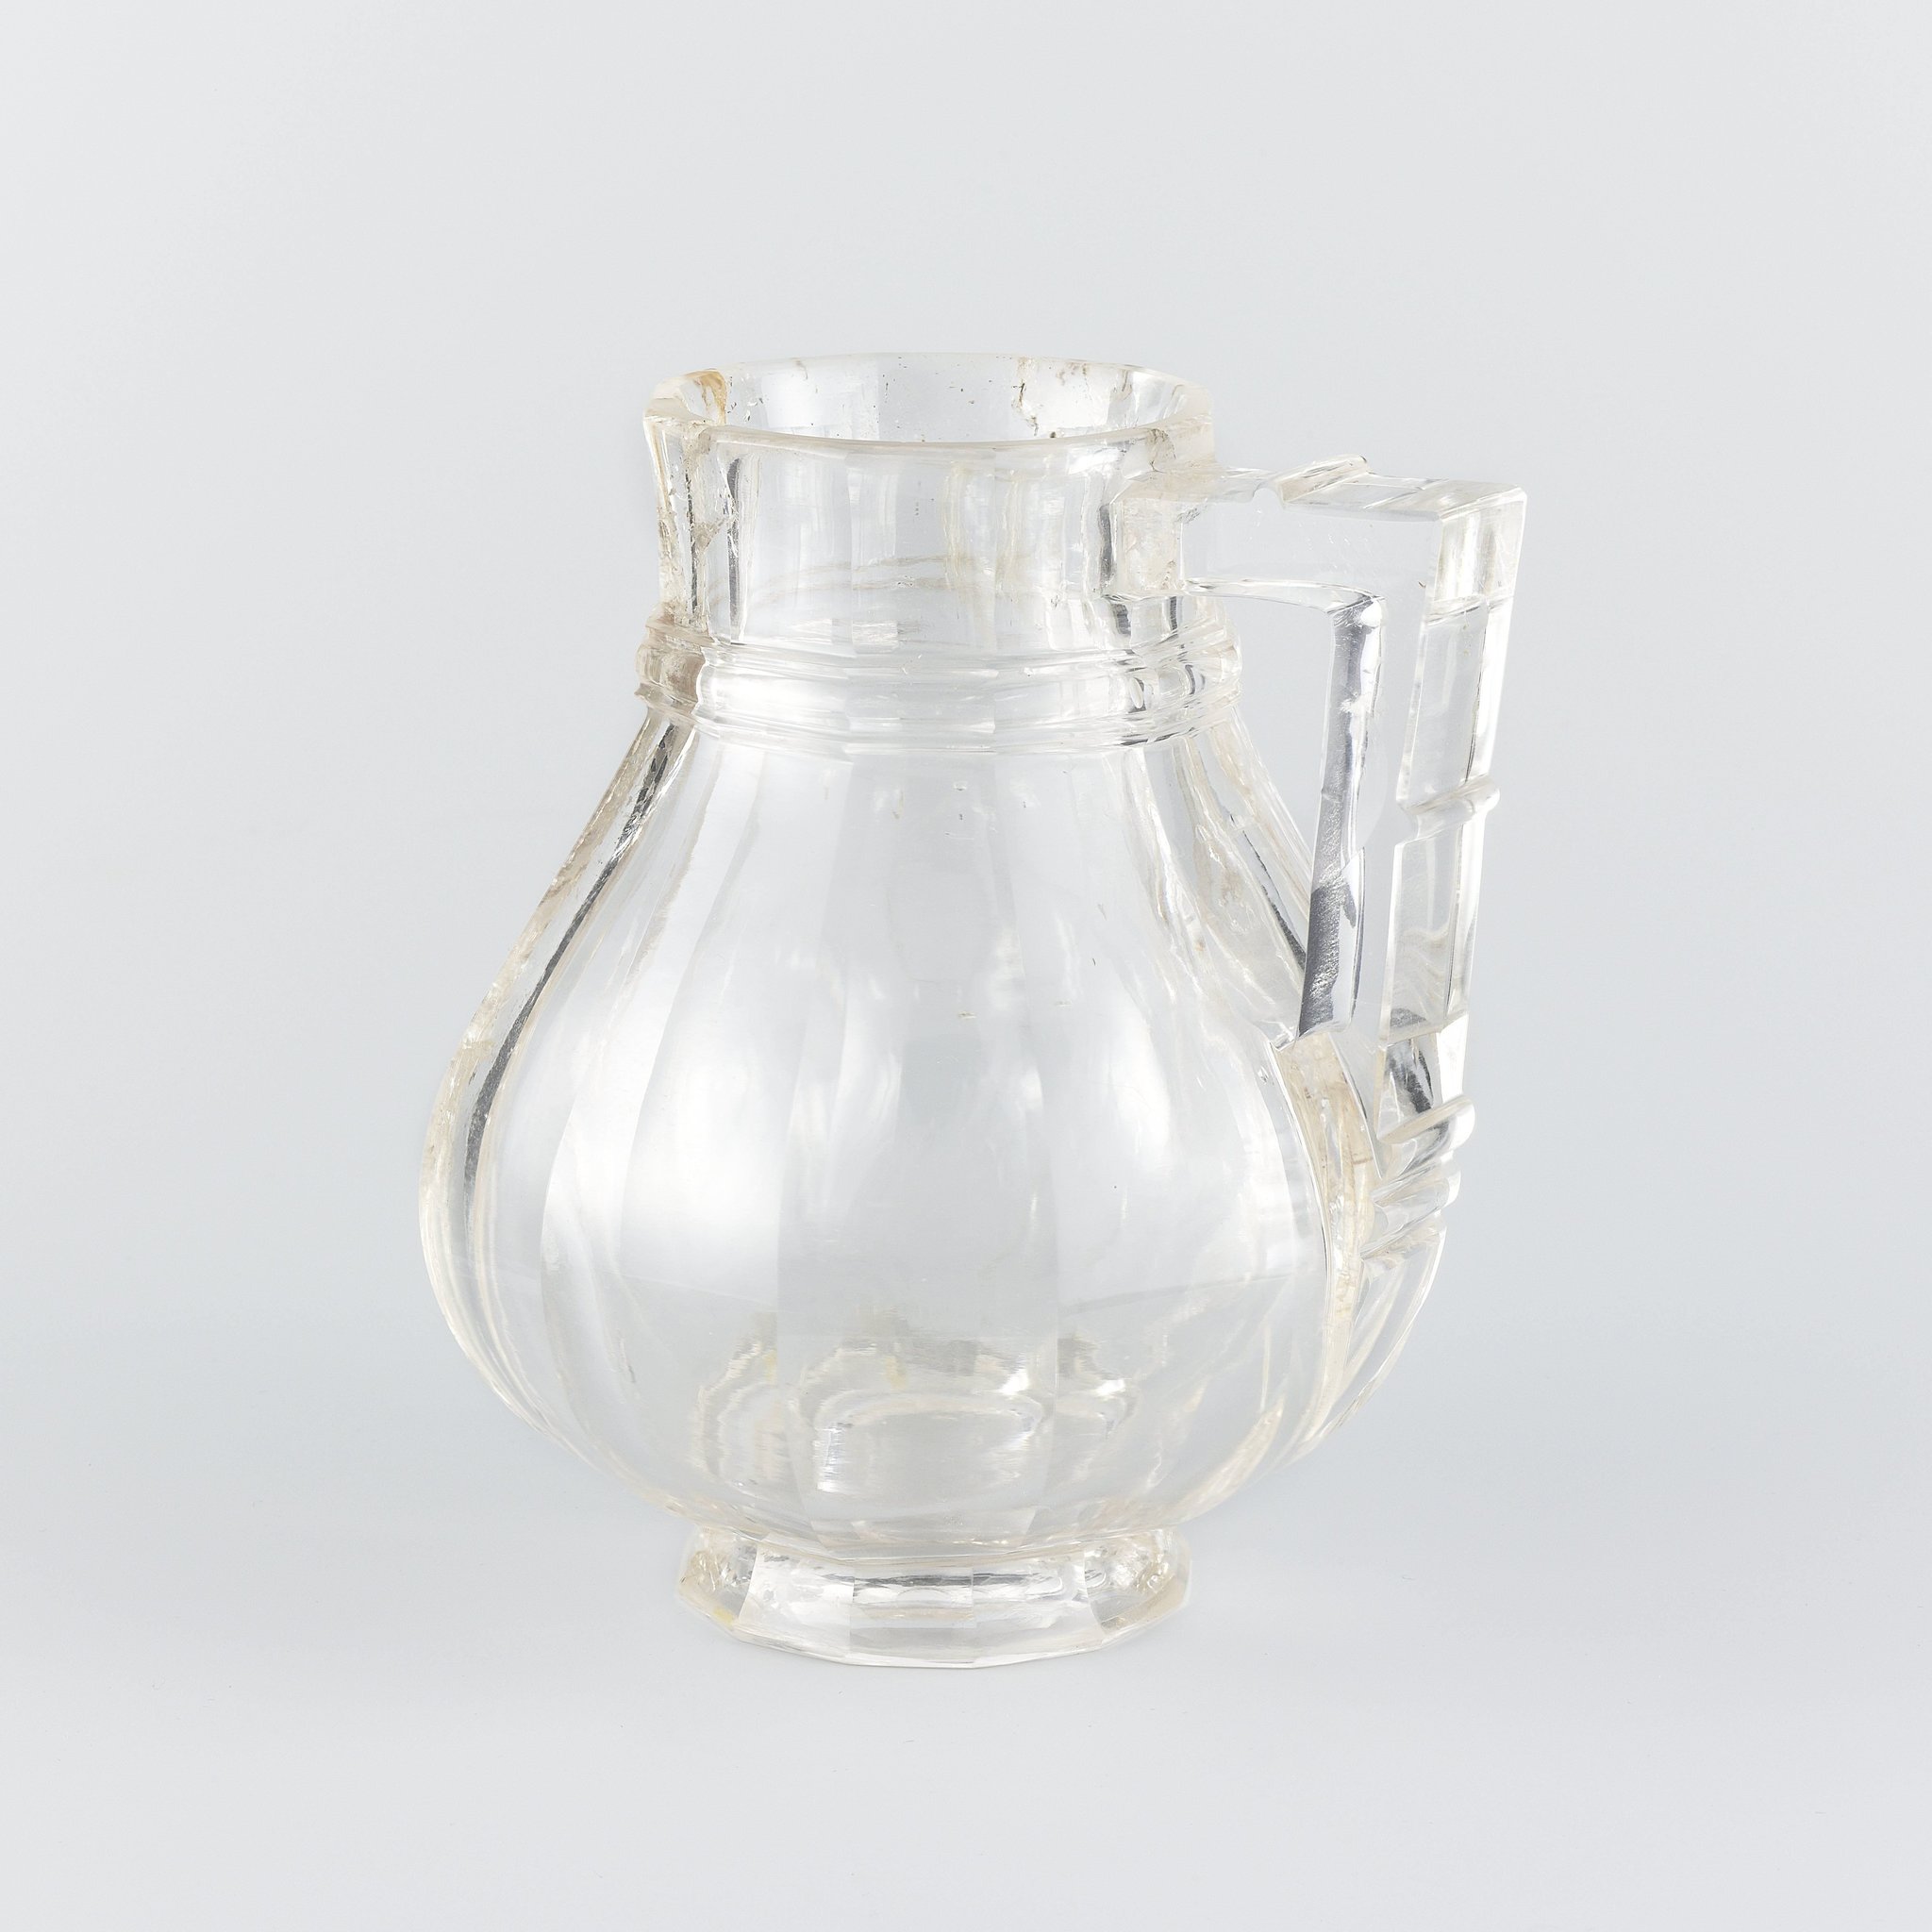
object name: ewer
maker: Anonymous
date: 1350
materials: silver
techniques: gilding, grinding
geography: southern italy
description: Kan van bergkristal met verguld zilveren monturen. Het peervormige vat is in twaalf verticale facetten geslepen. Rondom de hals loopt een bol profiel. Het in doorsnede vierkant rechthoekig oor heeft drie uitsteeksels. Op het montuur van voet en hals zijn landschappen gegraveerd. Het eveneens in twaalf facetten geslepen deksel heeft een in verguld zilver gevatte leeuwenkop als bekroning.